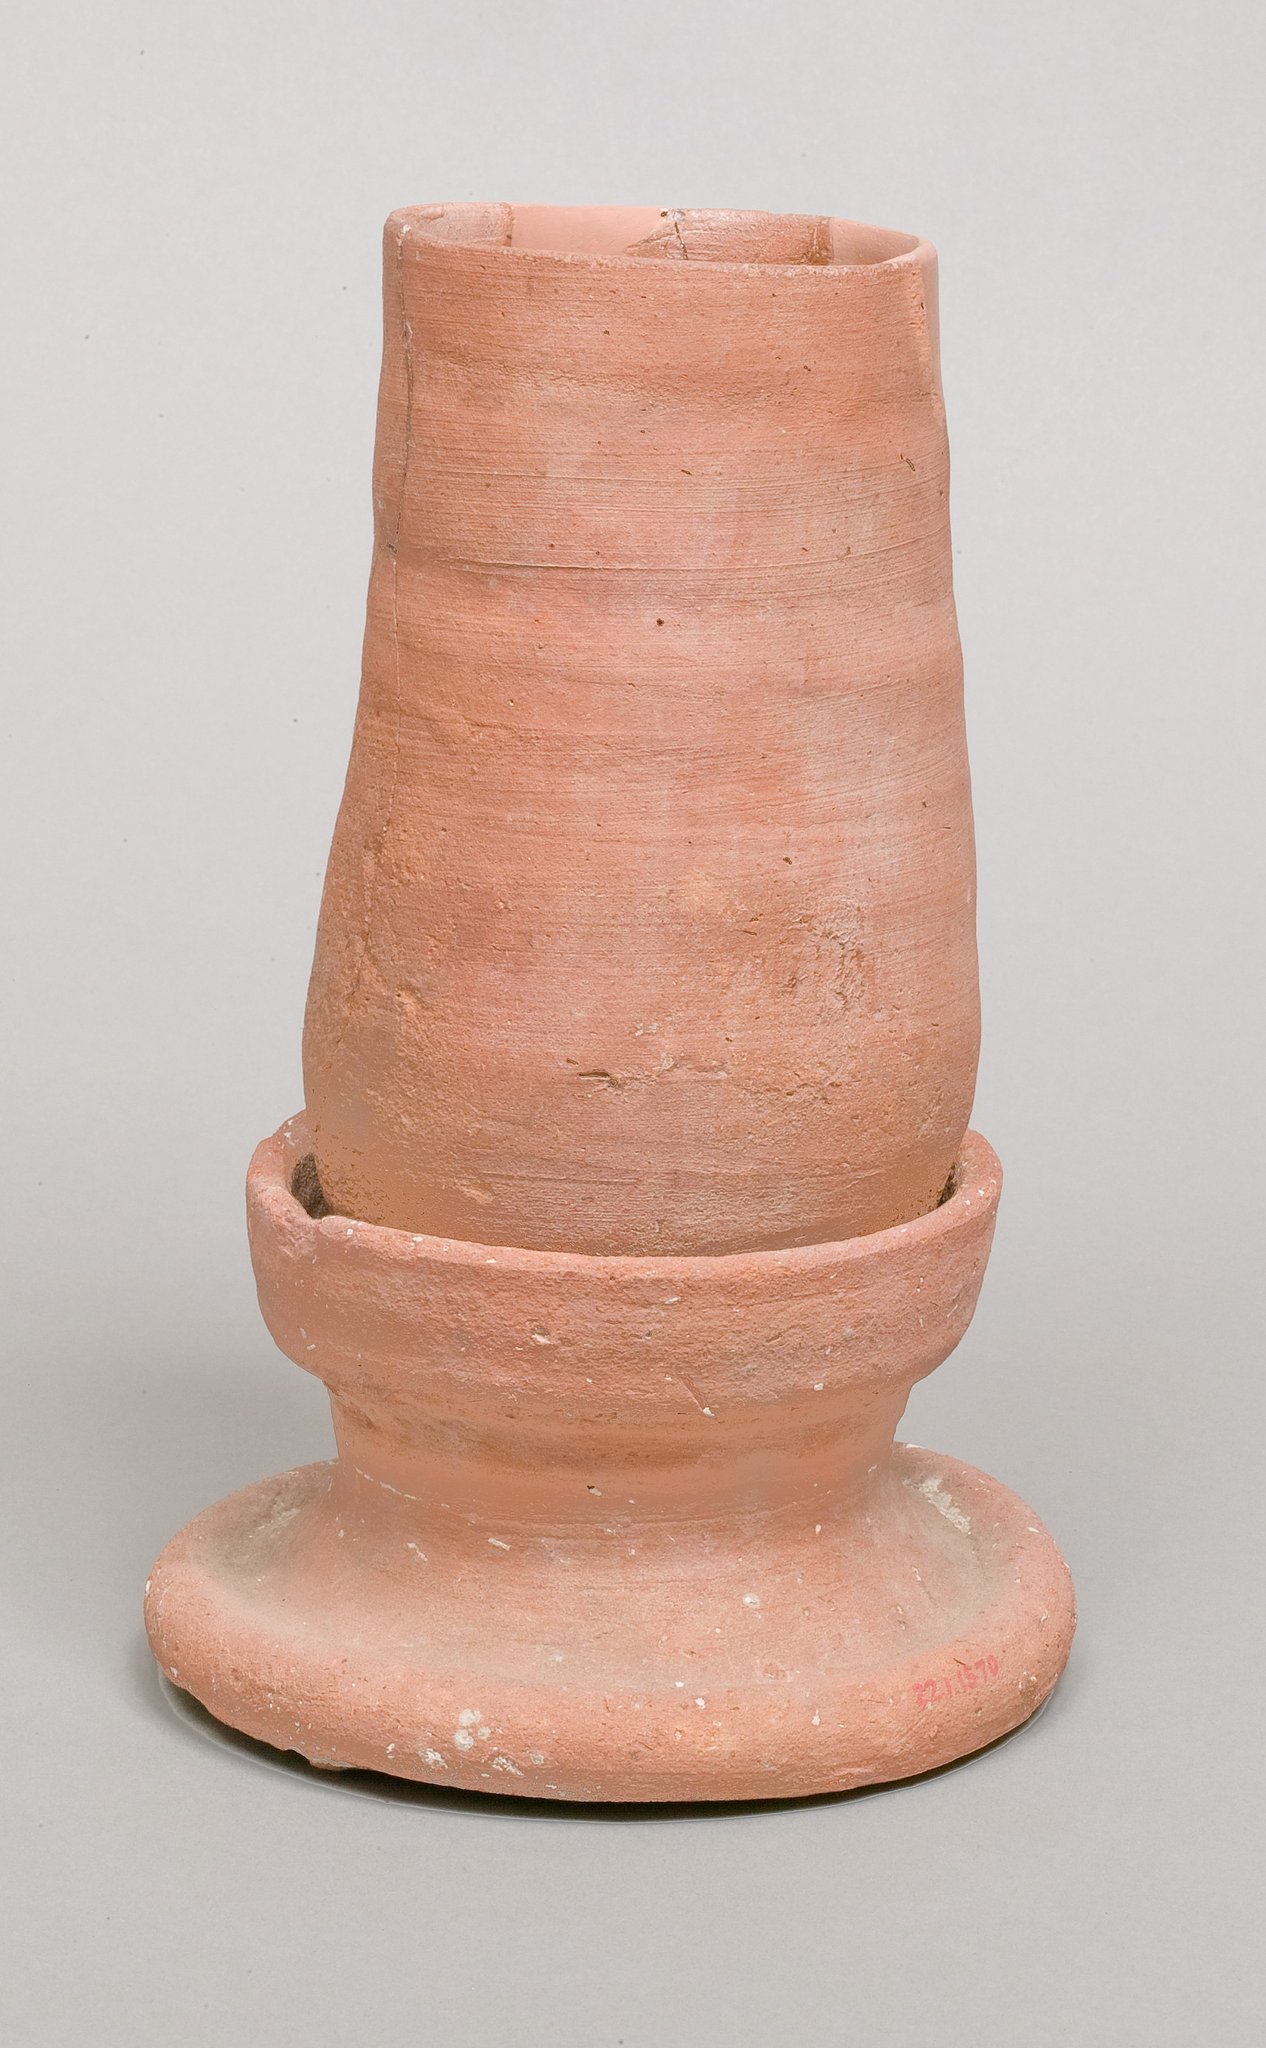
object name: jar with multiprofile neck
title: Situla shaped jar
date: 1981-1640 BCE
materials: paint, pottery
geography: egypt